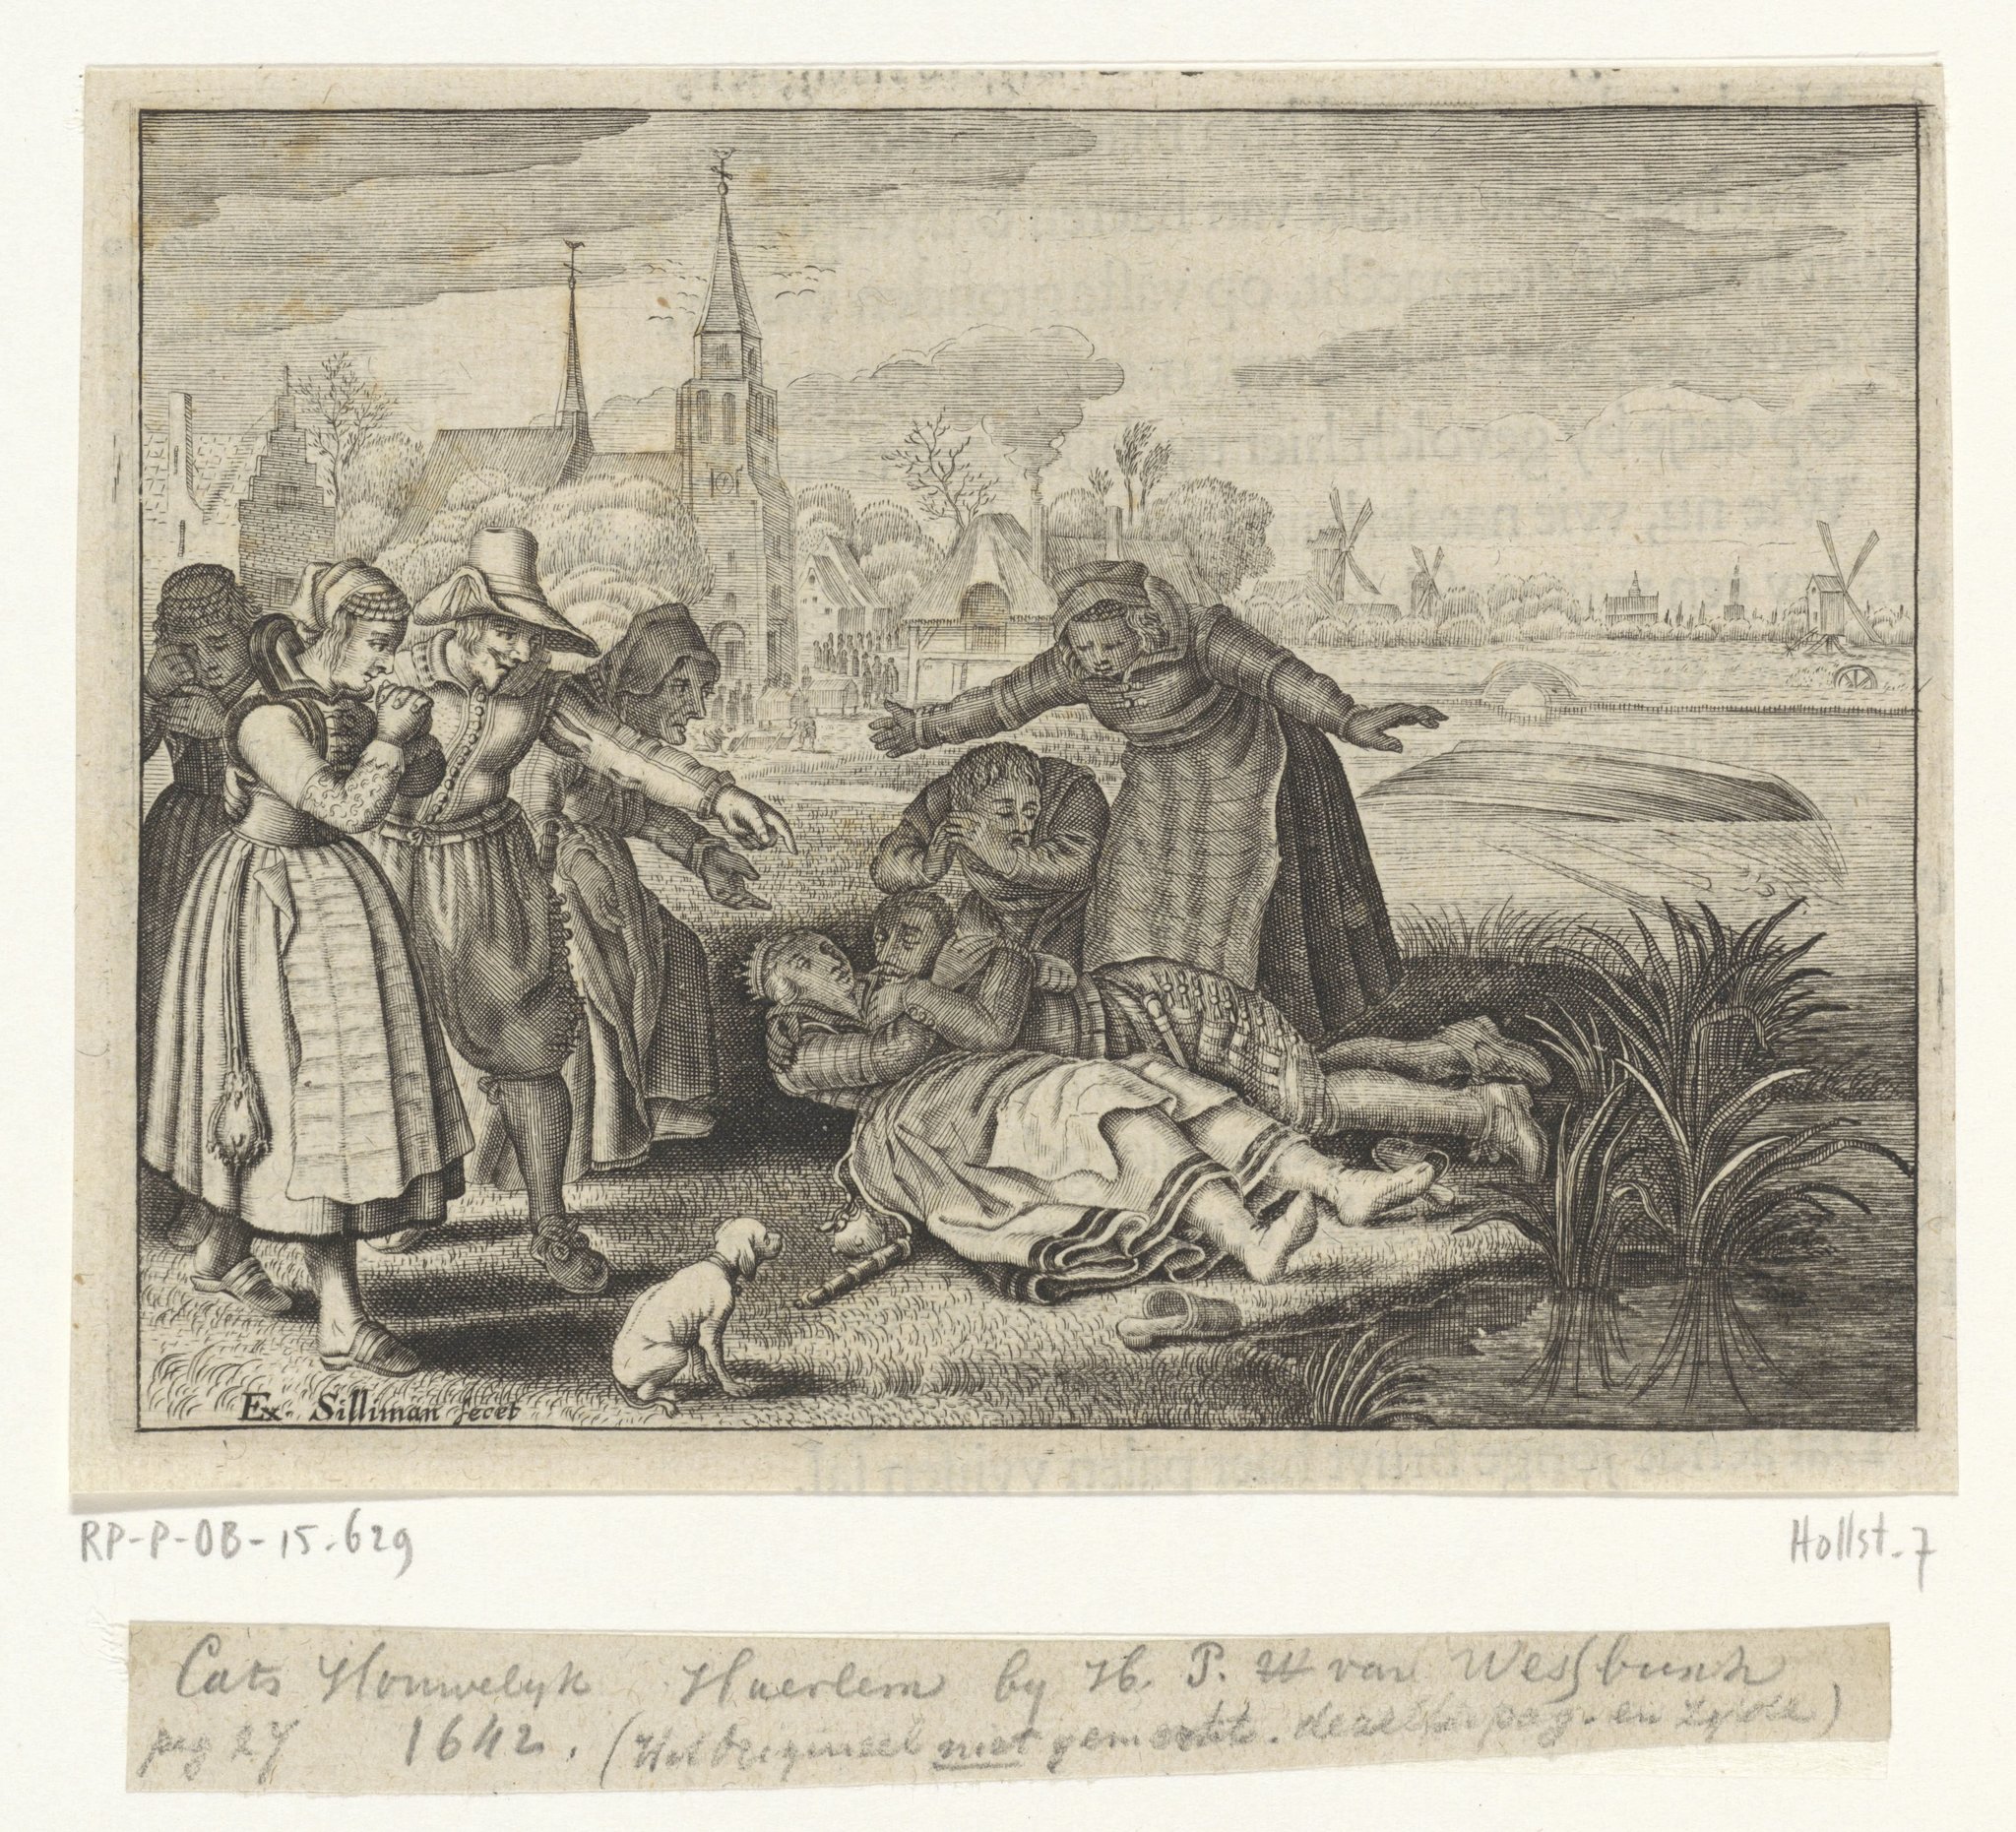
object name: print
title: De dood van een jong paar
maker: experiens sillemans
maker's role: painter, print maker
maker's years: 1611-1653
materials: paper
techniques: engraving, letterpress printing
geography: amsterdam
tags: drowned person, address at open grave, cortege, funeral procession, mourning the dead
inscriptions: collector's mark: Lugt 2228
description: Op de oever van een rivier treurt een groep mannen en vrouwen over een verdronken man en vrouw, die innig omstrengeld op de grond liggen. Op de rivier ligt nog hun omgeslagen boot. Op de achtergrond een dorp met molens en een kerk, waarlangs een begrafenisstoet trekt. Twee kisten staan naast het geopende graf.